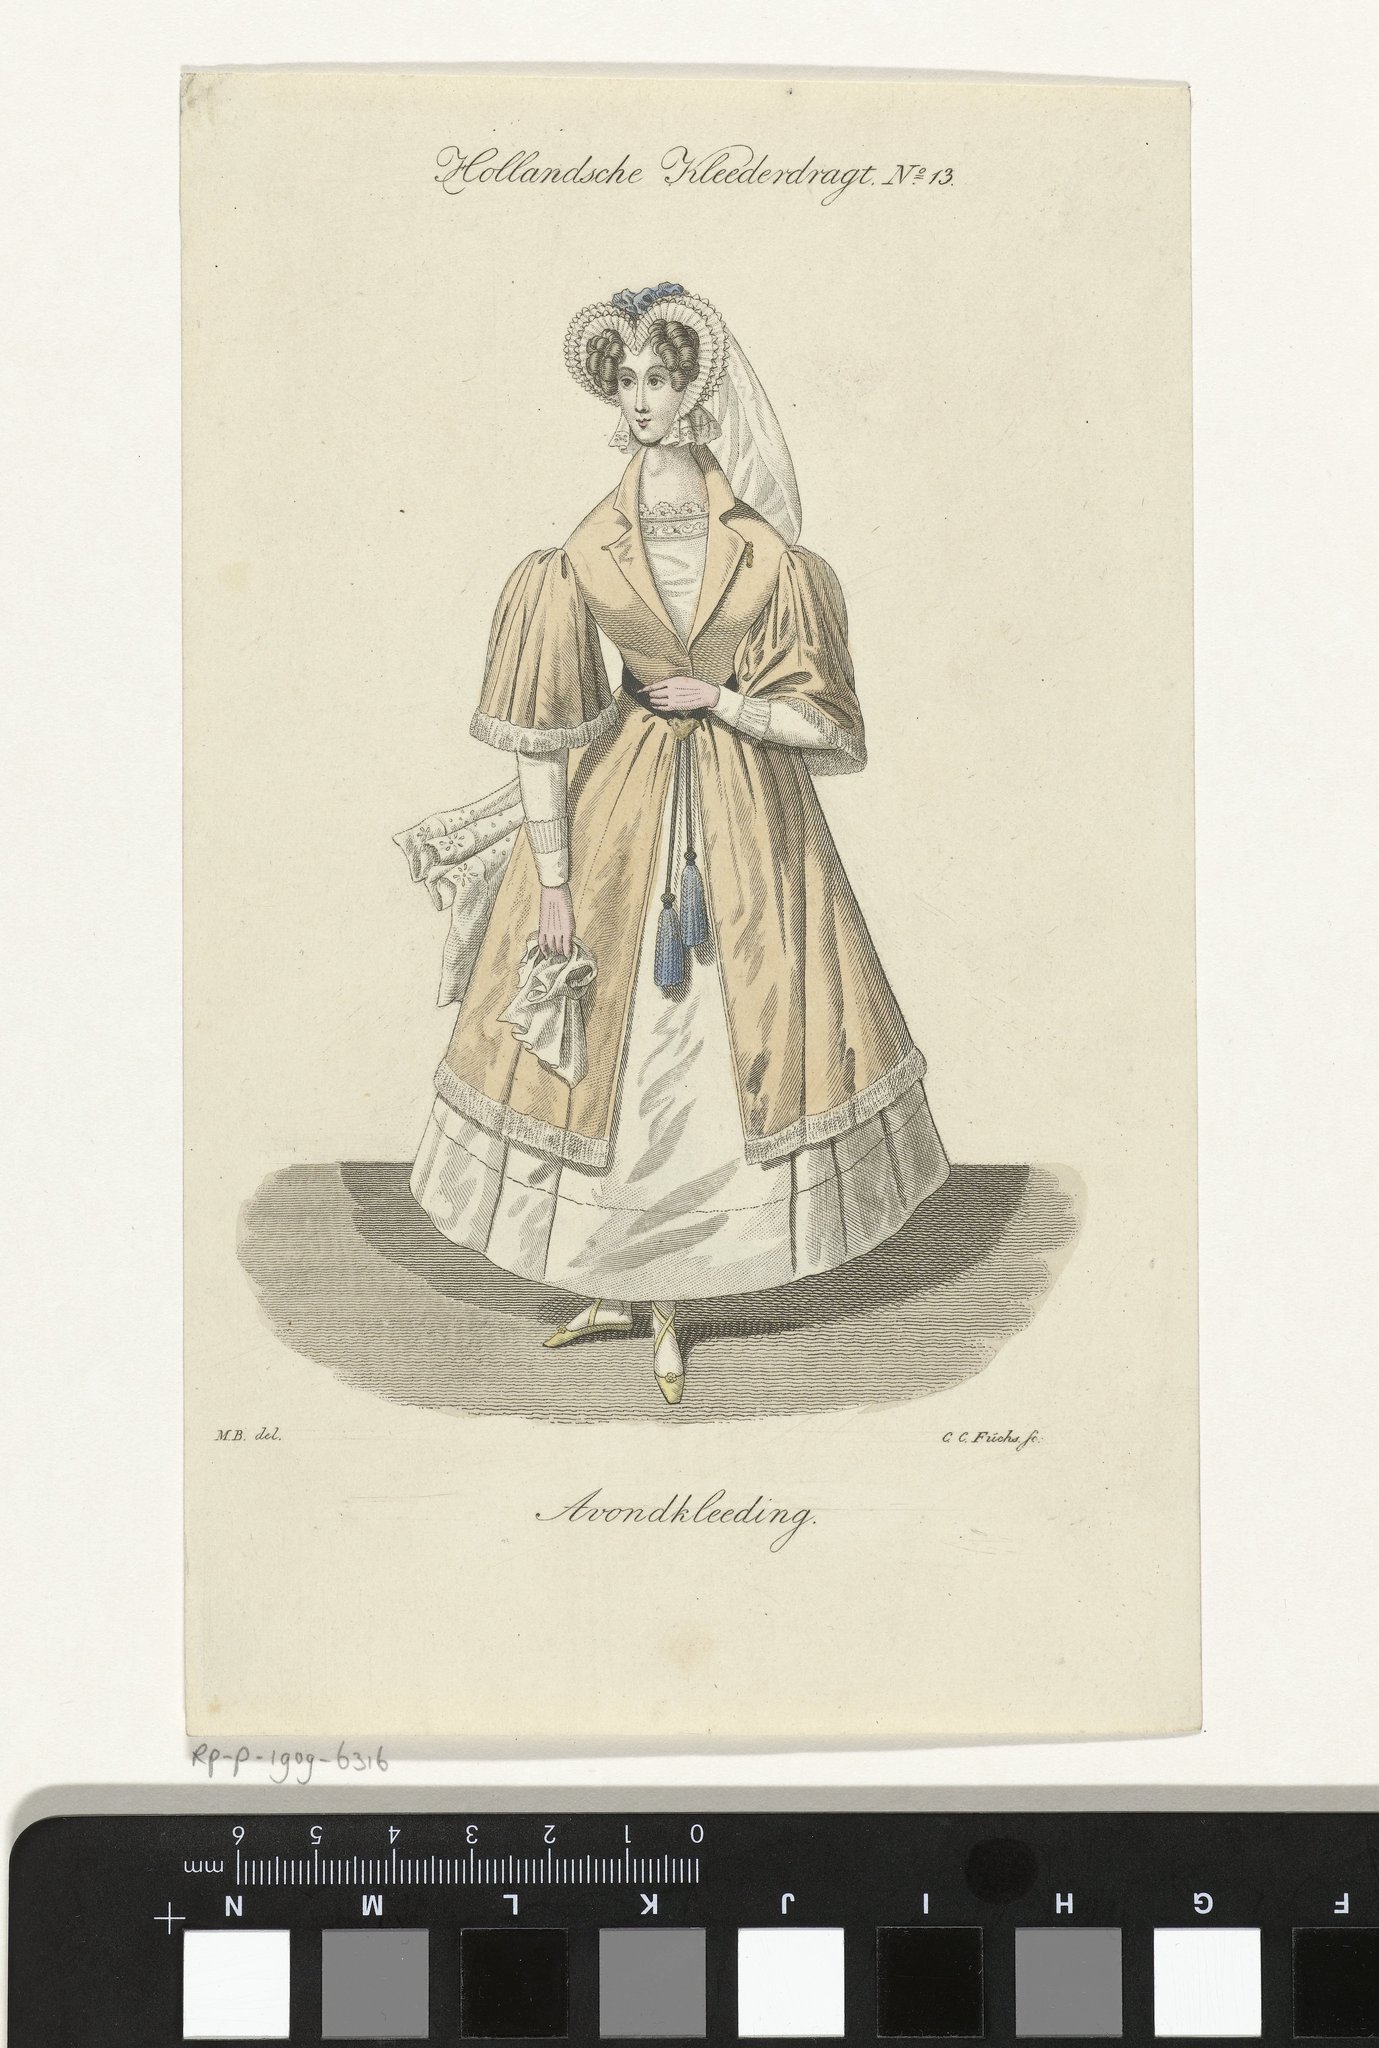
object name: print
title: Vrouw in avondkleding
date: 1802-1855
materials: paper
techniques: etching, hand coloring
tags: handkerchief (+ women's clothes), dress, gown: evening dress (+ women's clothes), veil (+ women's clothes), dress, gown (+ women's clothes)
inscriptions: collector's mark: Lugt 2228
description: Een dame draagt een jurk met gele mantel. Op haar hoofd een bijpassend hoofdkapje en in haar hand een zakdoek.